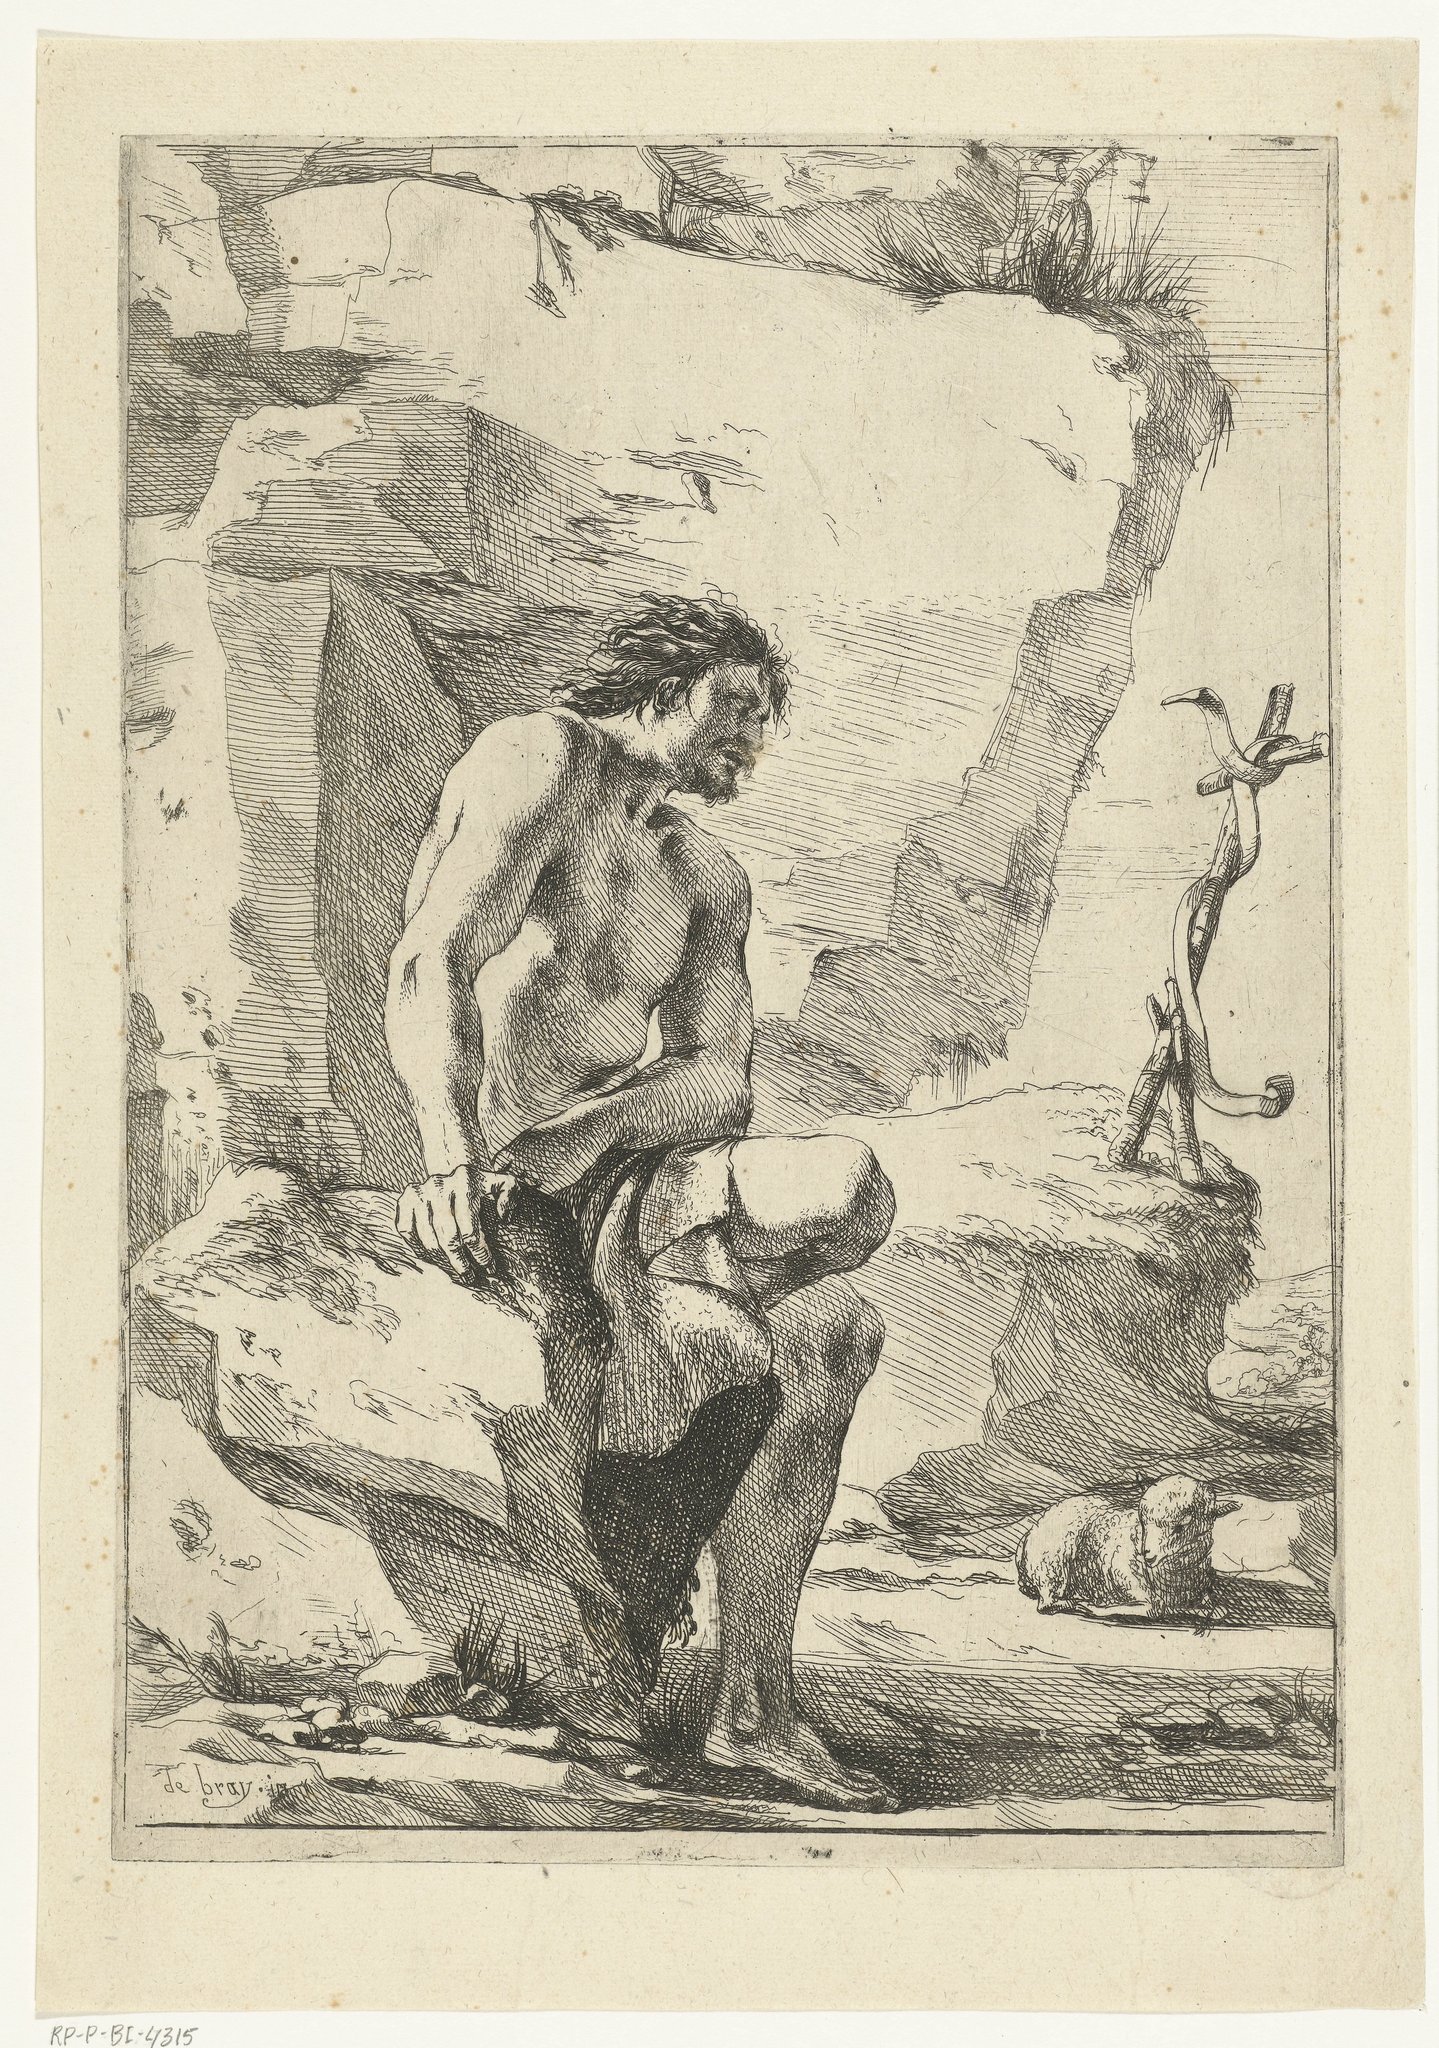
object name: print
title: Johannes de Doper met kruis en lam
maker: jan de bray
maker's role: draughtsman, print maker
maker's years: 1627-1697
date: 1637-1697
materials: paper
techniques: etching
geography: netherlands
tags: john the baptist; possible attributes: book, reed cross, baptismal cup, honeycomb, lamb, staff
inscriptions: collector's mark: Lugt 240